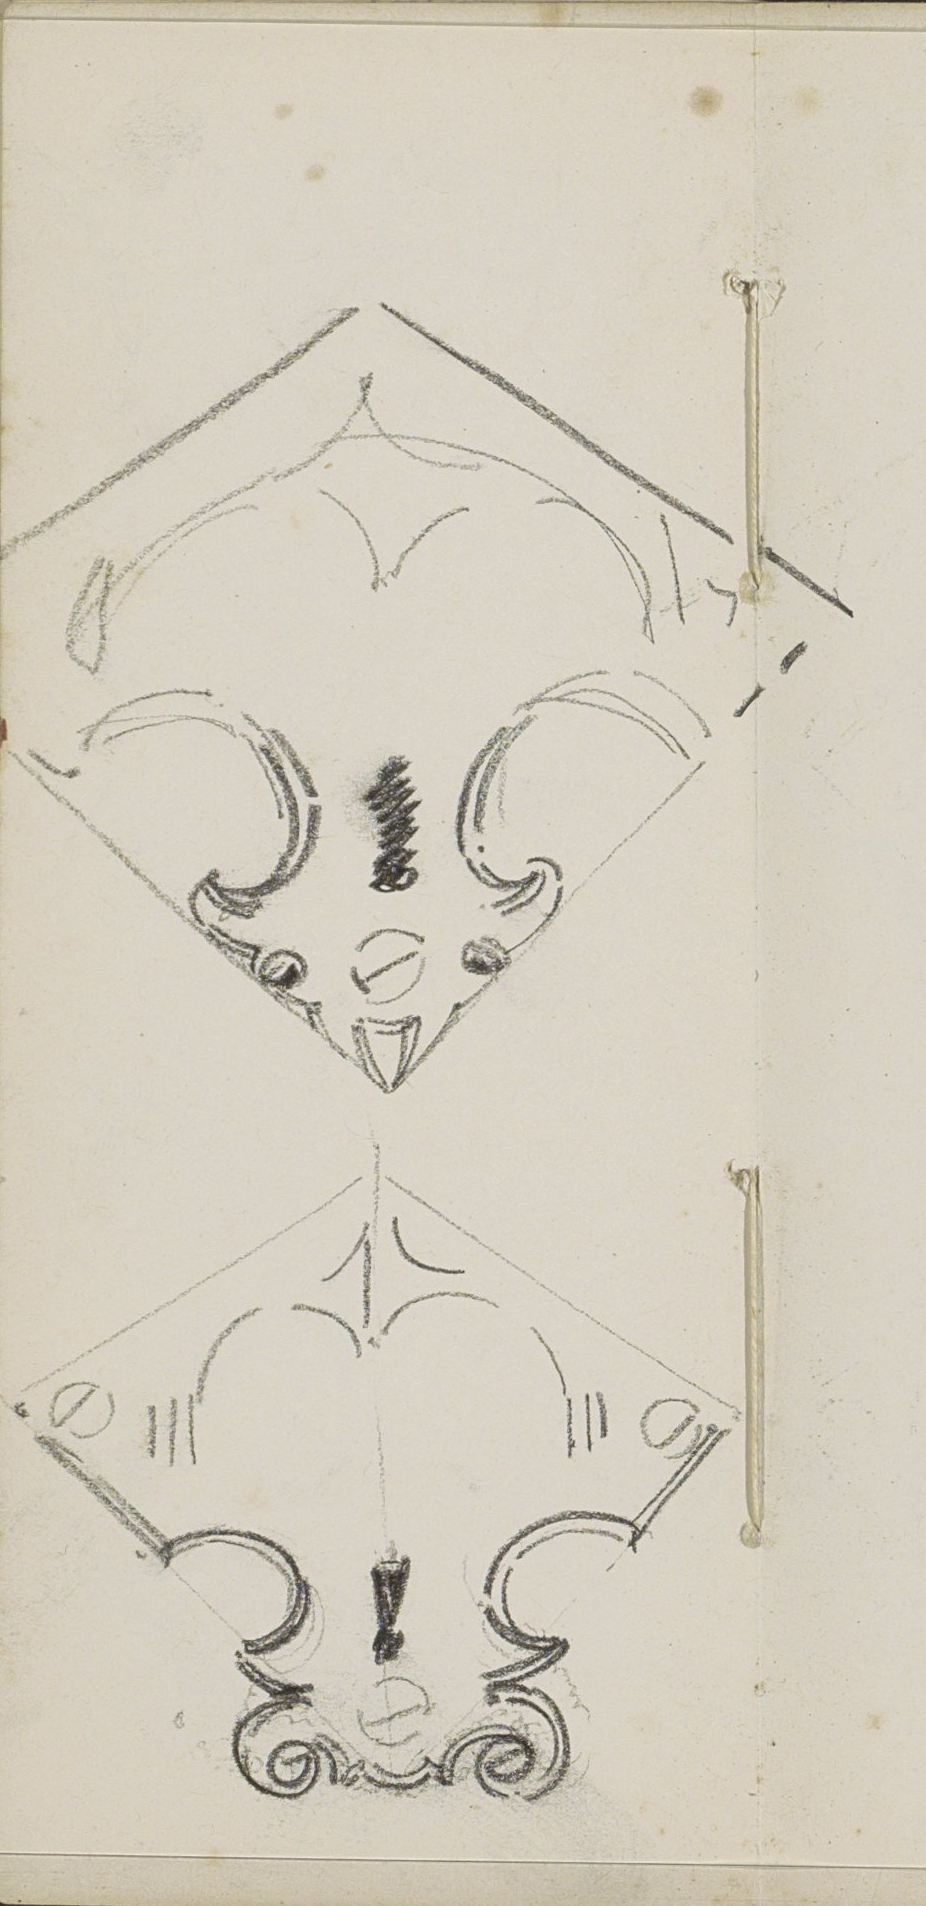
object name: sketchbook leaf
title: Ruitvormige ornamenten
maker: gerrit willem dijsselhof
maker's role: designer, draughtsman, print maker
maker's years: 1866-1924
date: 1876-1924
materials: chalk, paper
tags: lock ~ door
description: Blad 33 verso uit een schetsboek met 40 bladen.